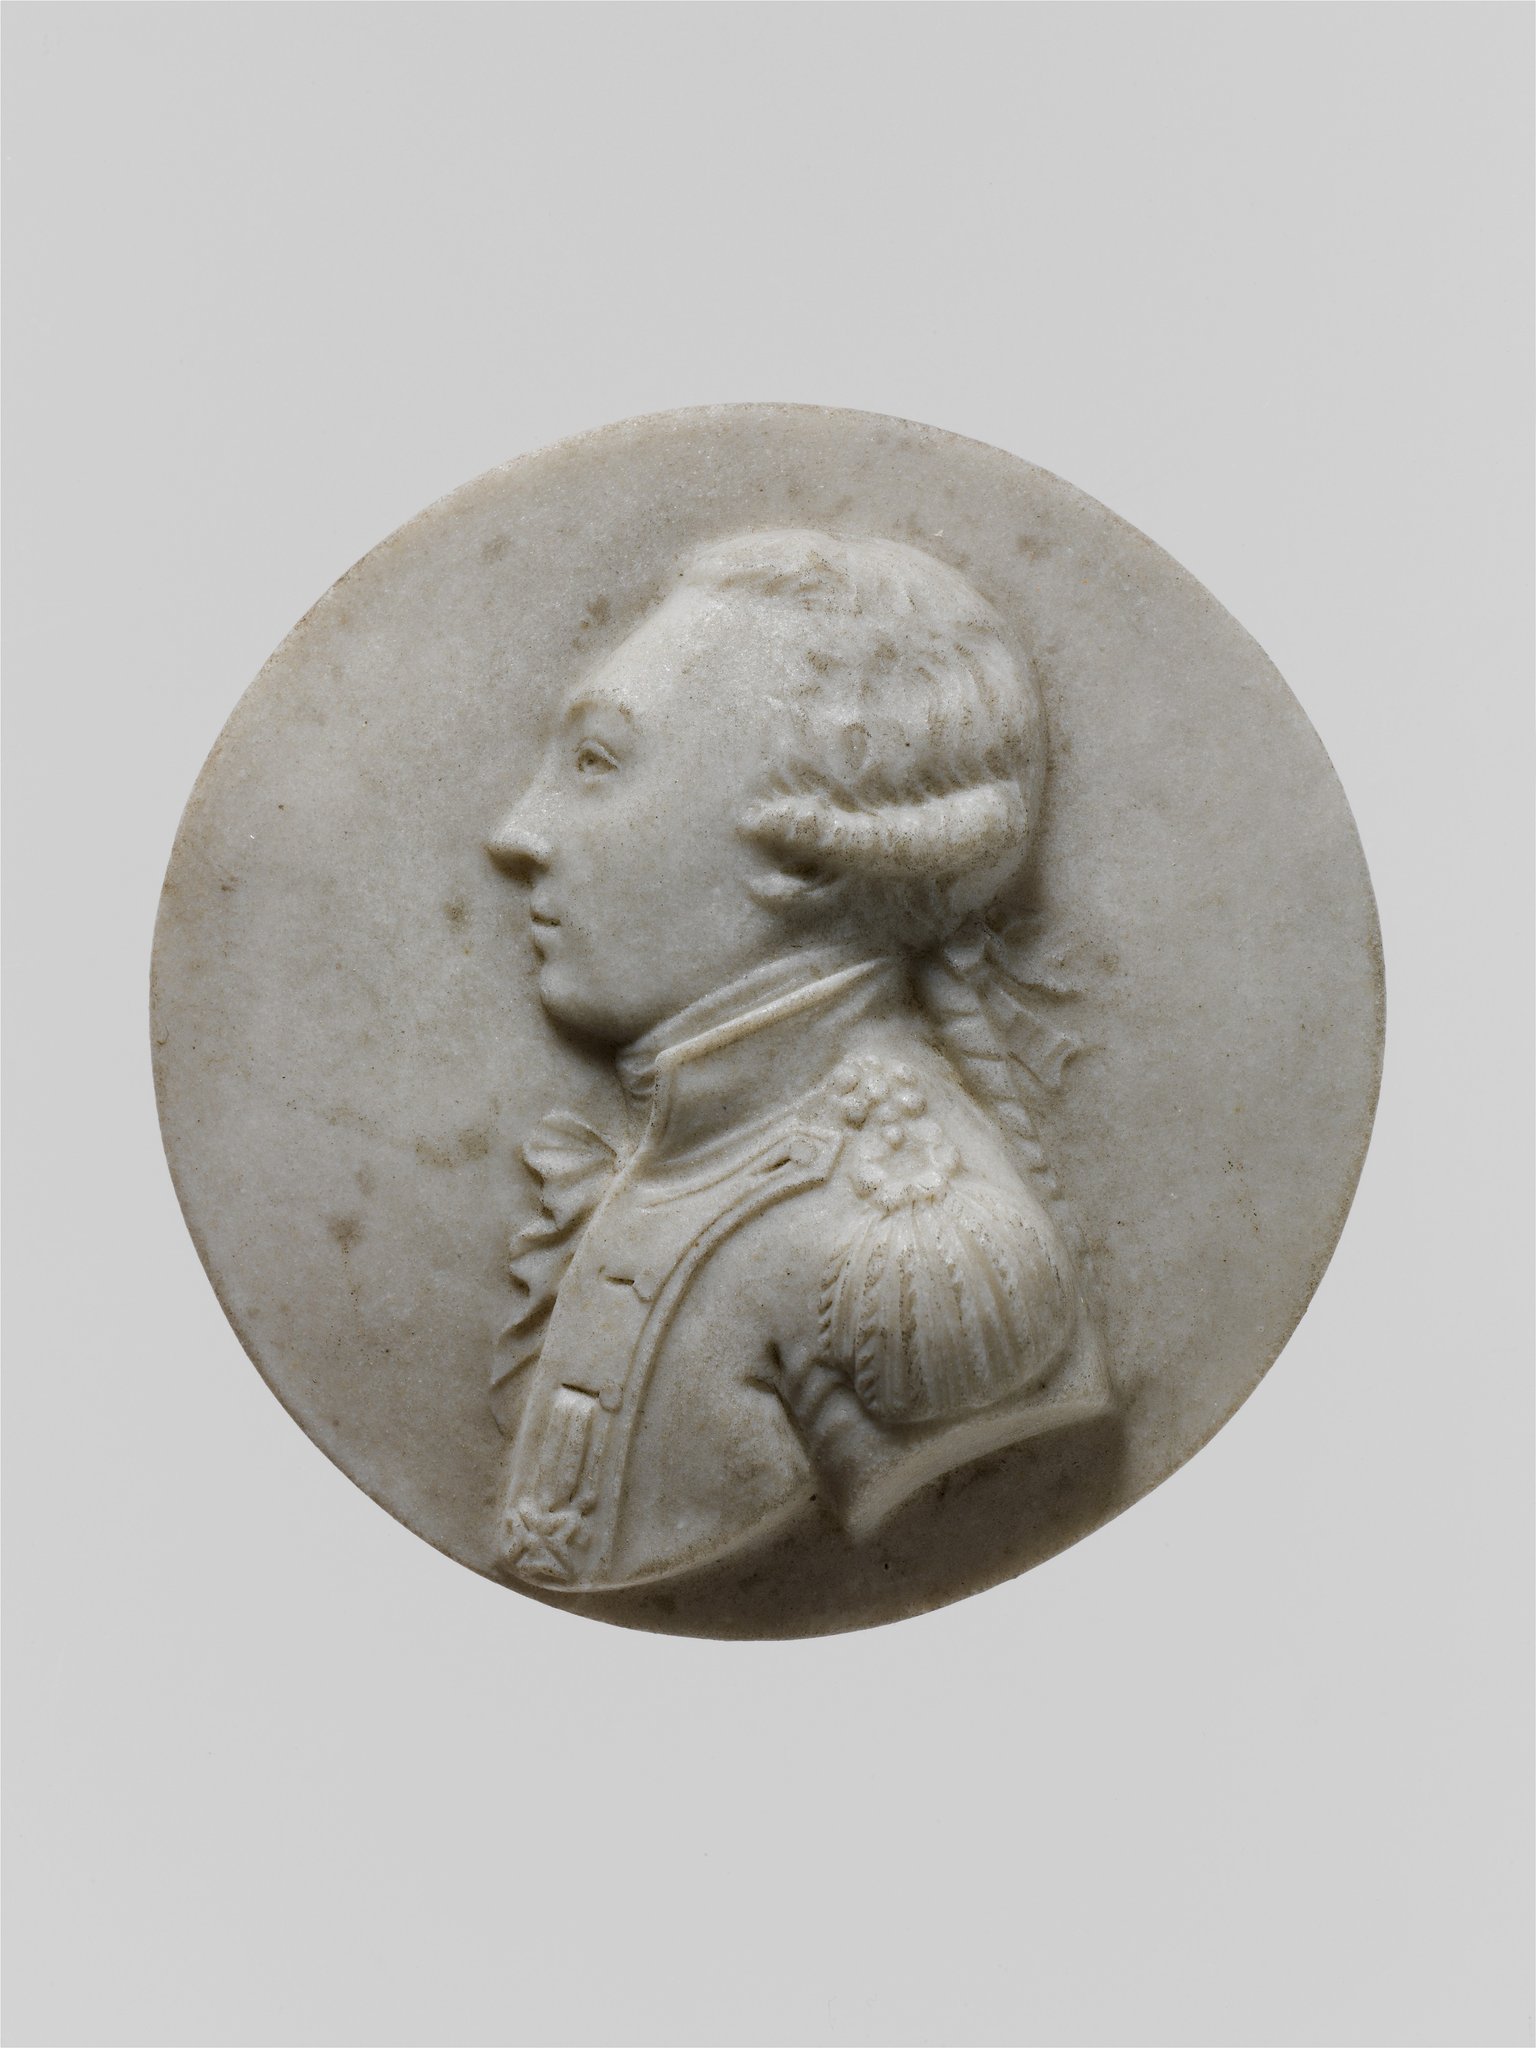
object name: medallion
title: Medallion of the Marquis de Lafayette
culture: french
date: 1775-1883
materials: porcelain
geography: france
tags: men,profiles,marquis de lafayette